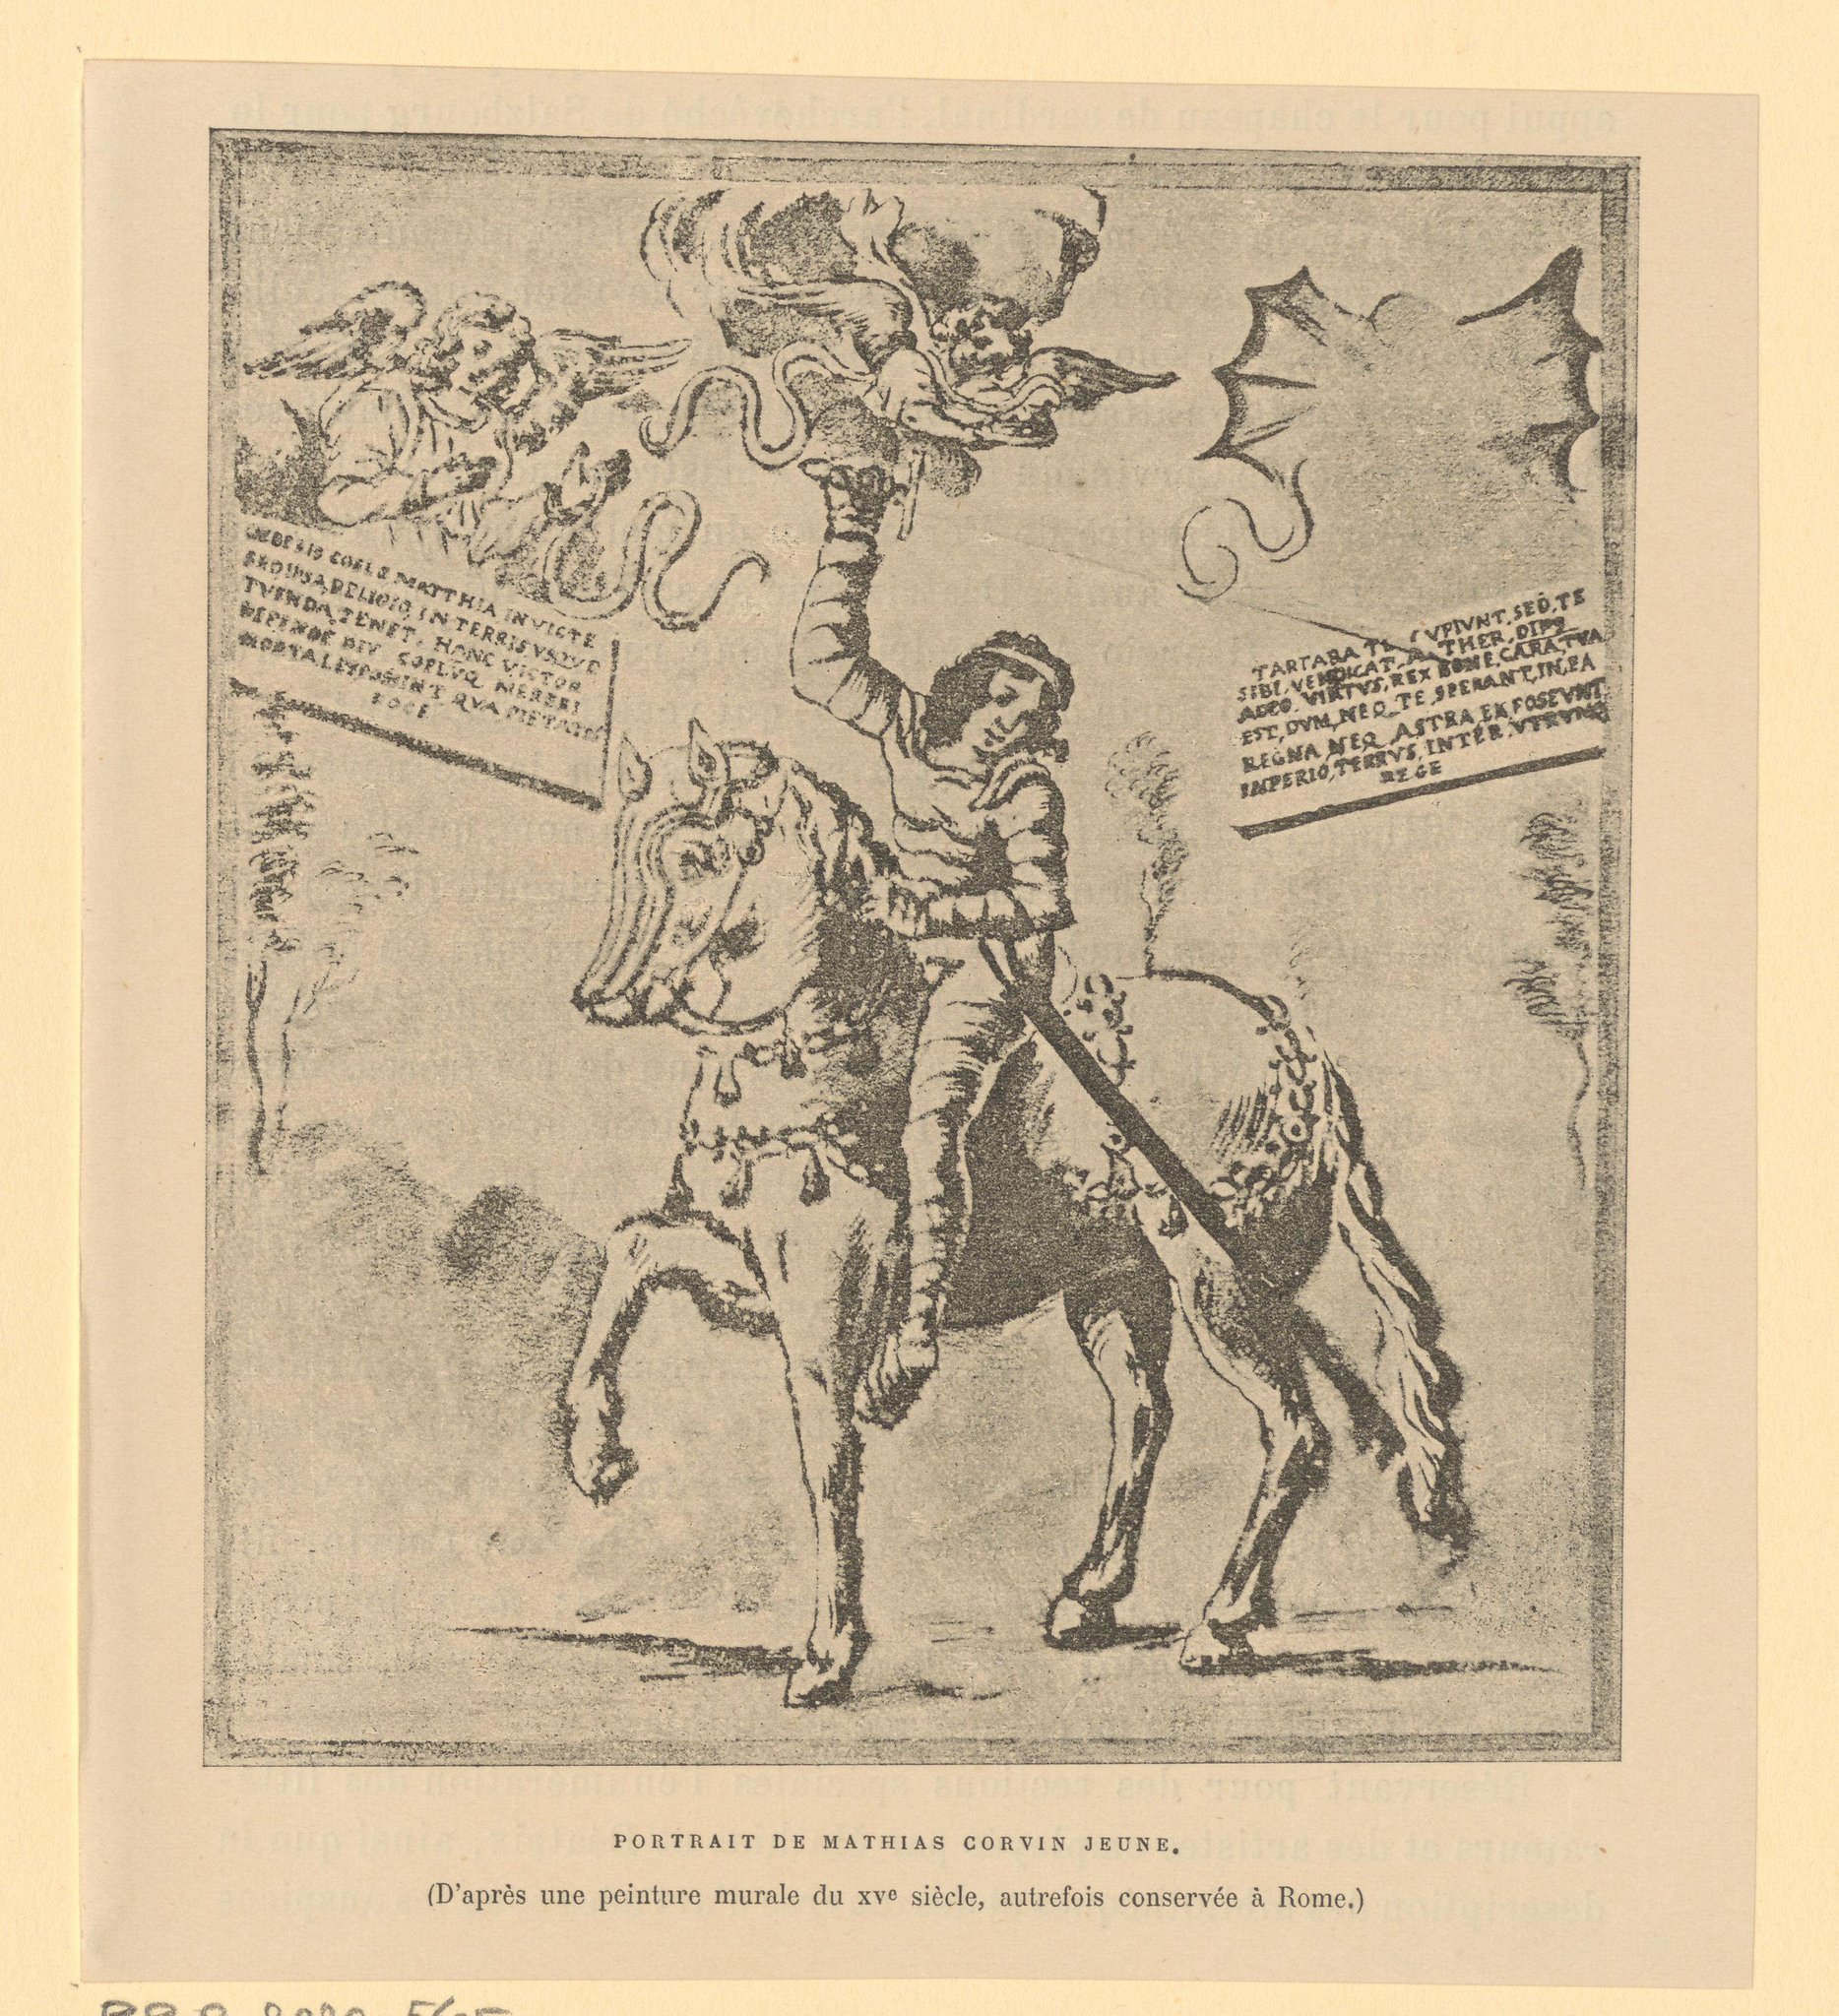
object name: photomechanical print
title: Ruiterportret van Matthias Corvinus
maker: Anonymous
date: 1894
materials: paper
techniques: letterpress printing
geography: rome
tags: vienna, equestrian state-portrait, historical persons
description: Prent uit: Gazette des Beaux-Arts (1894), vol. 12, p. 361.